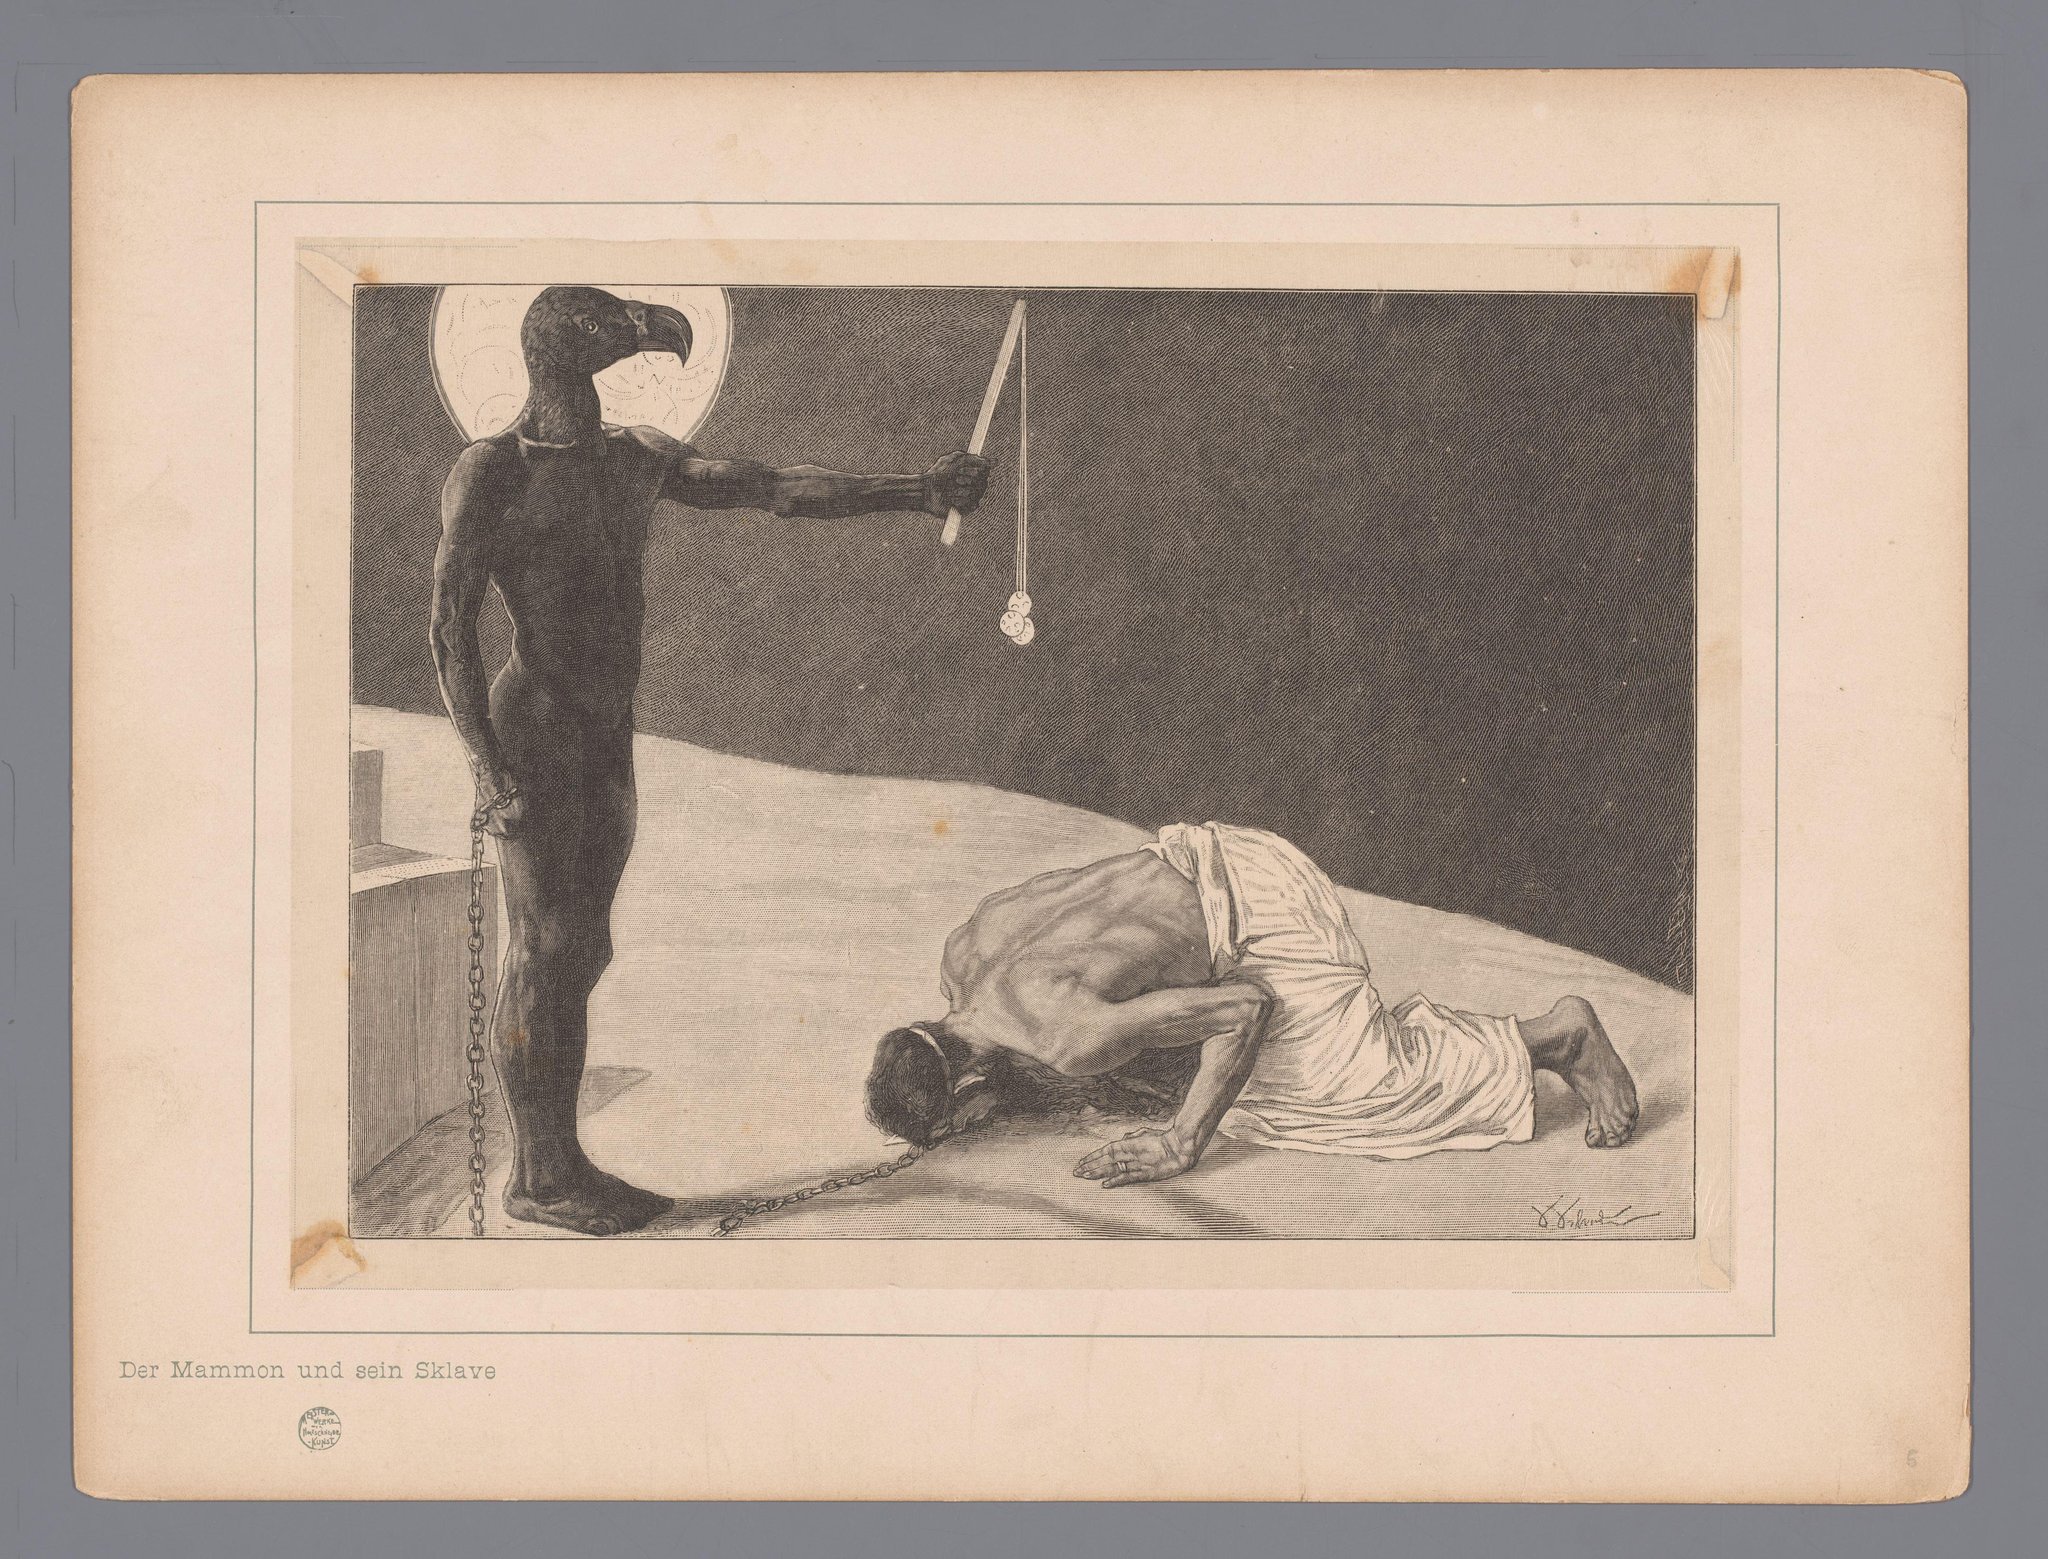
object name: print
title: Der Mammon und sein Sklave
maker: johann jakob weber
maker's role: publisher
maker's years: 1803-1880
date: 1813-1880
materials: paper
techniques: lithograph, engraving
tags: people worshipping mammon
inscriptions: collector's mark: Lugt 2228